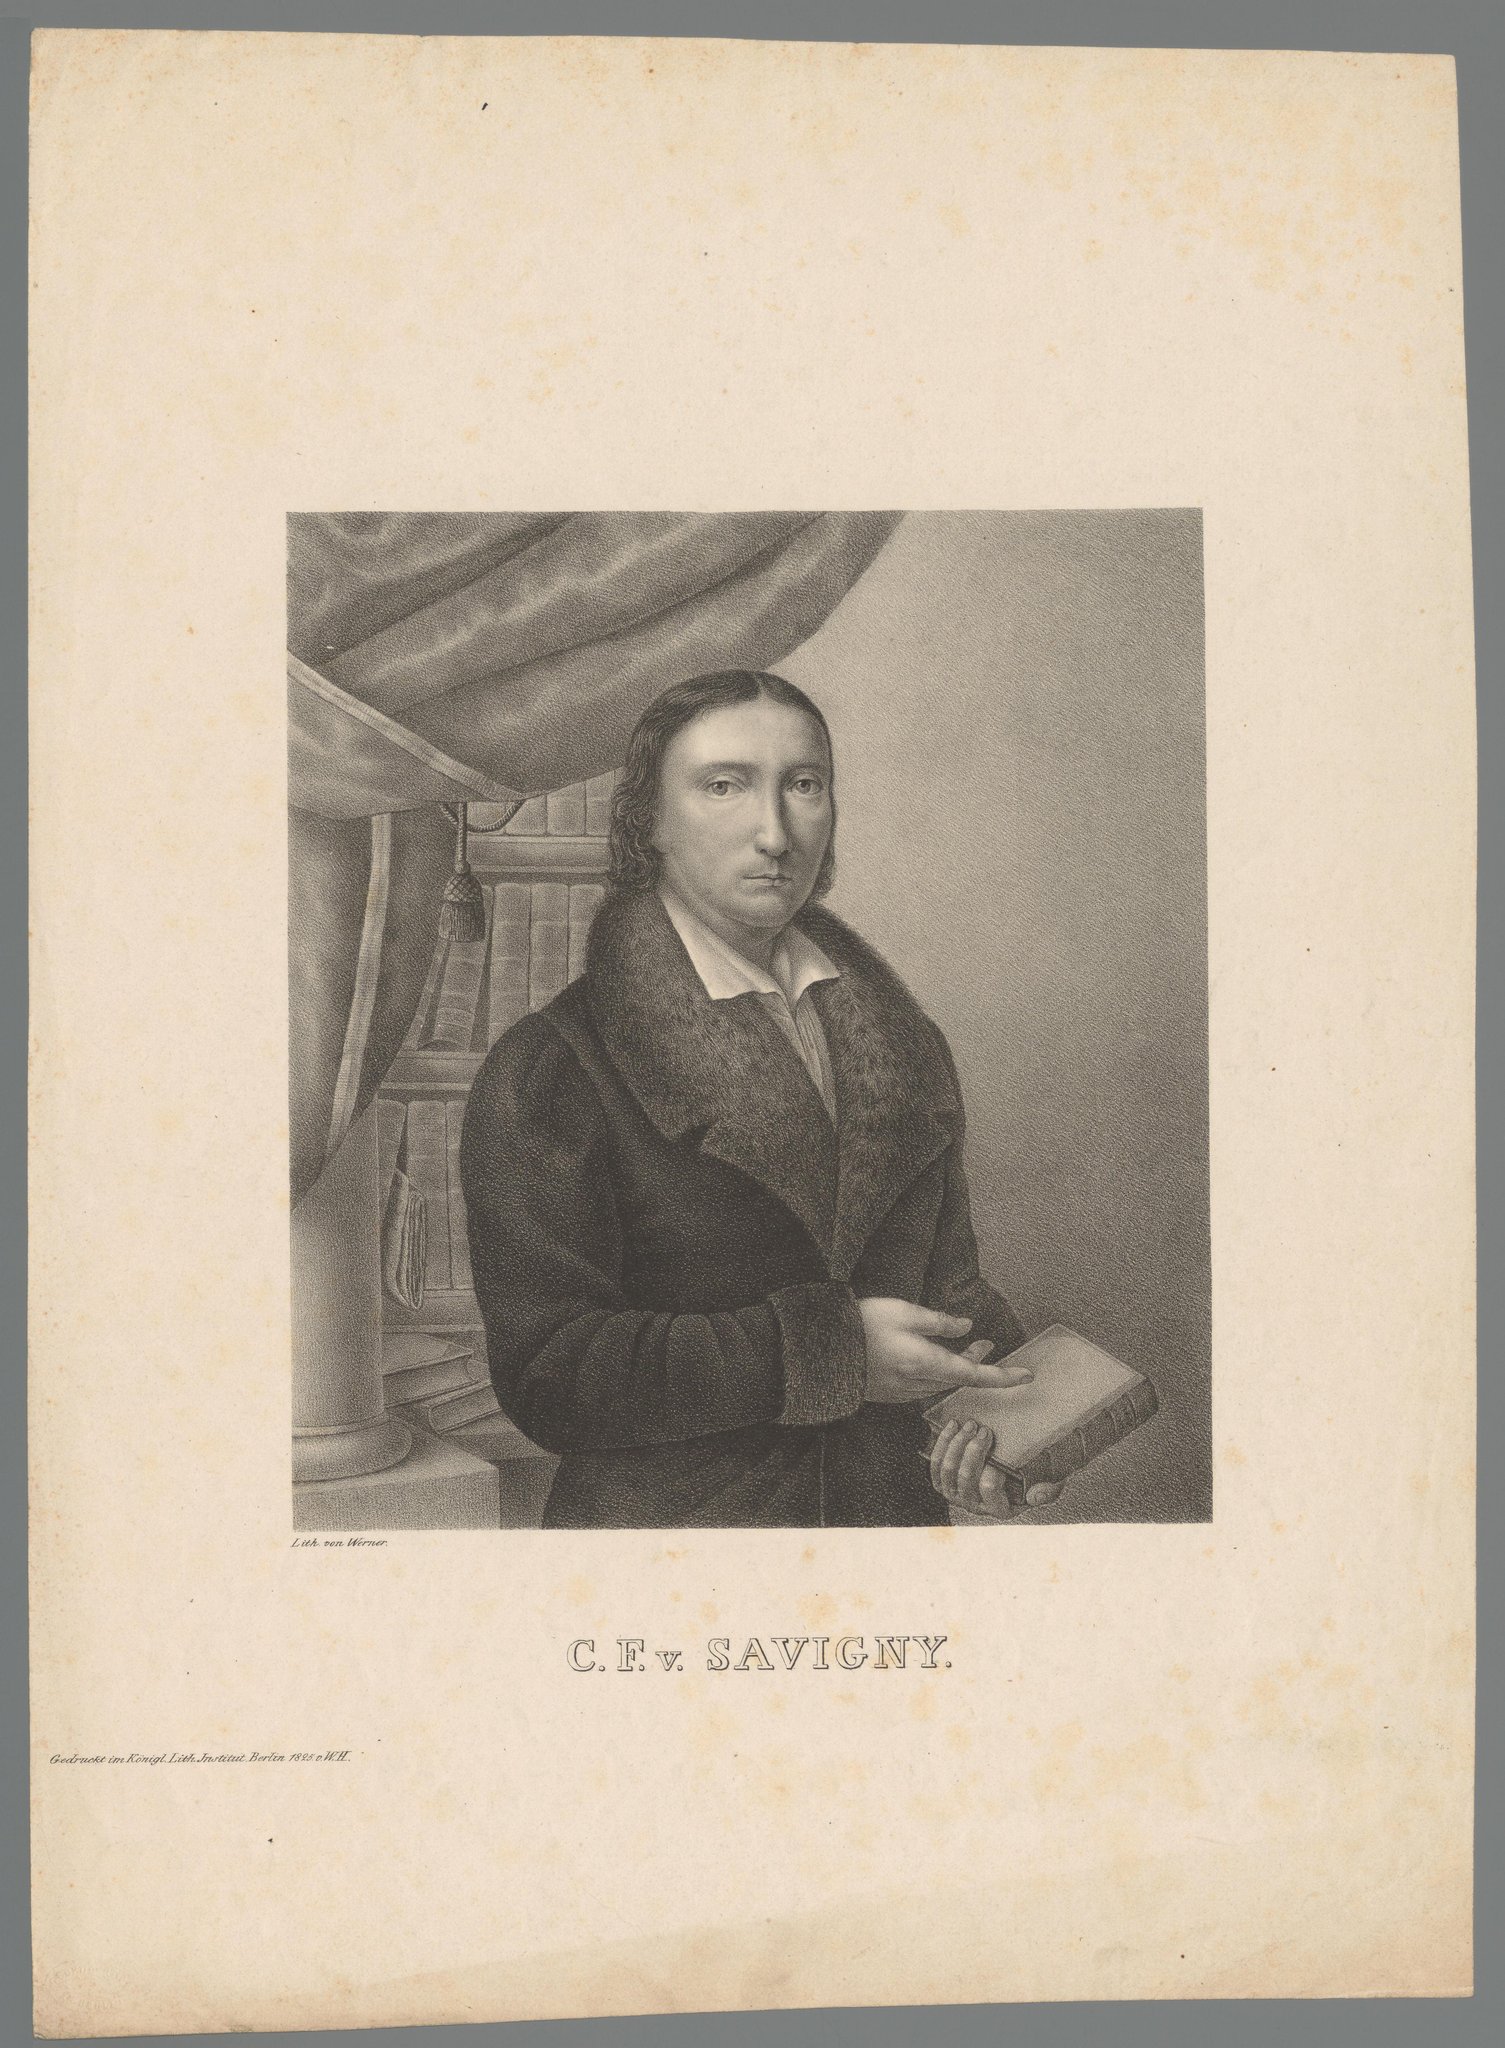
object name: print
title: C.F. v. Savigny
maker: wilhelm werner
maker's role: print maker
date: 1825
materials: paper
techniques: lithograph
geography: berlin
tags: bookshelves, adult man, historical persons, book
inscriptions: collector's mark: Lugt 2228